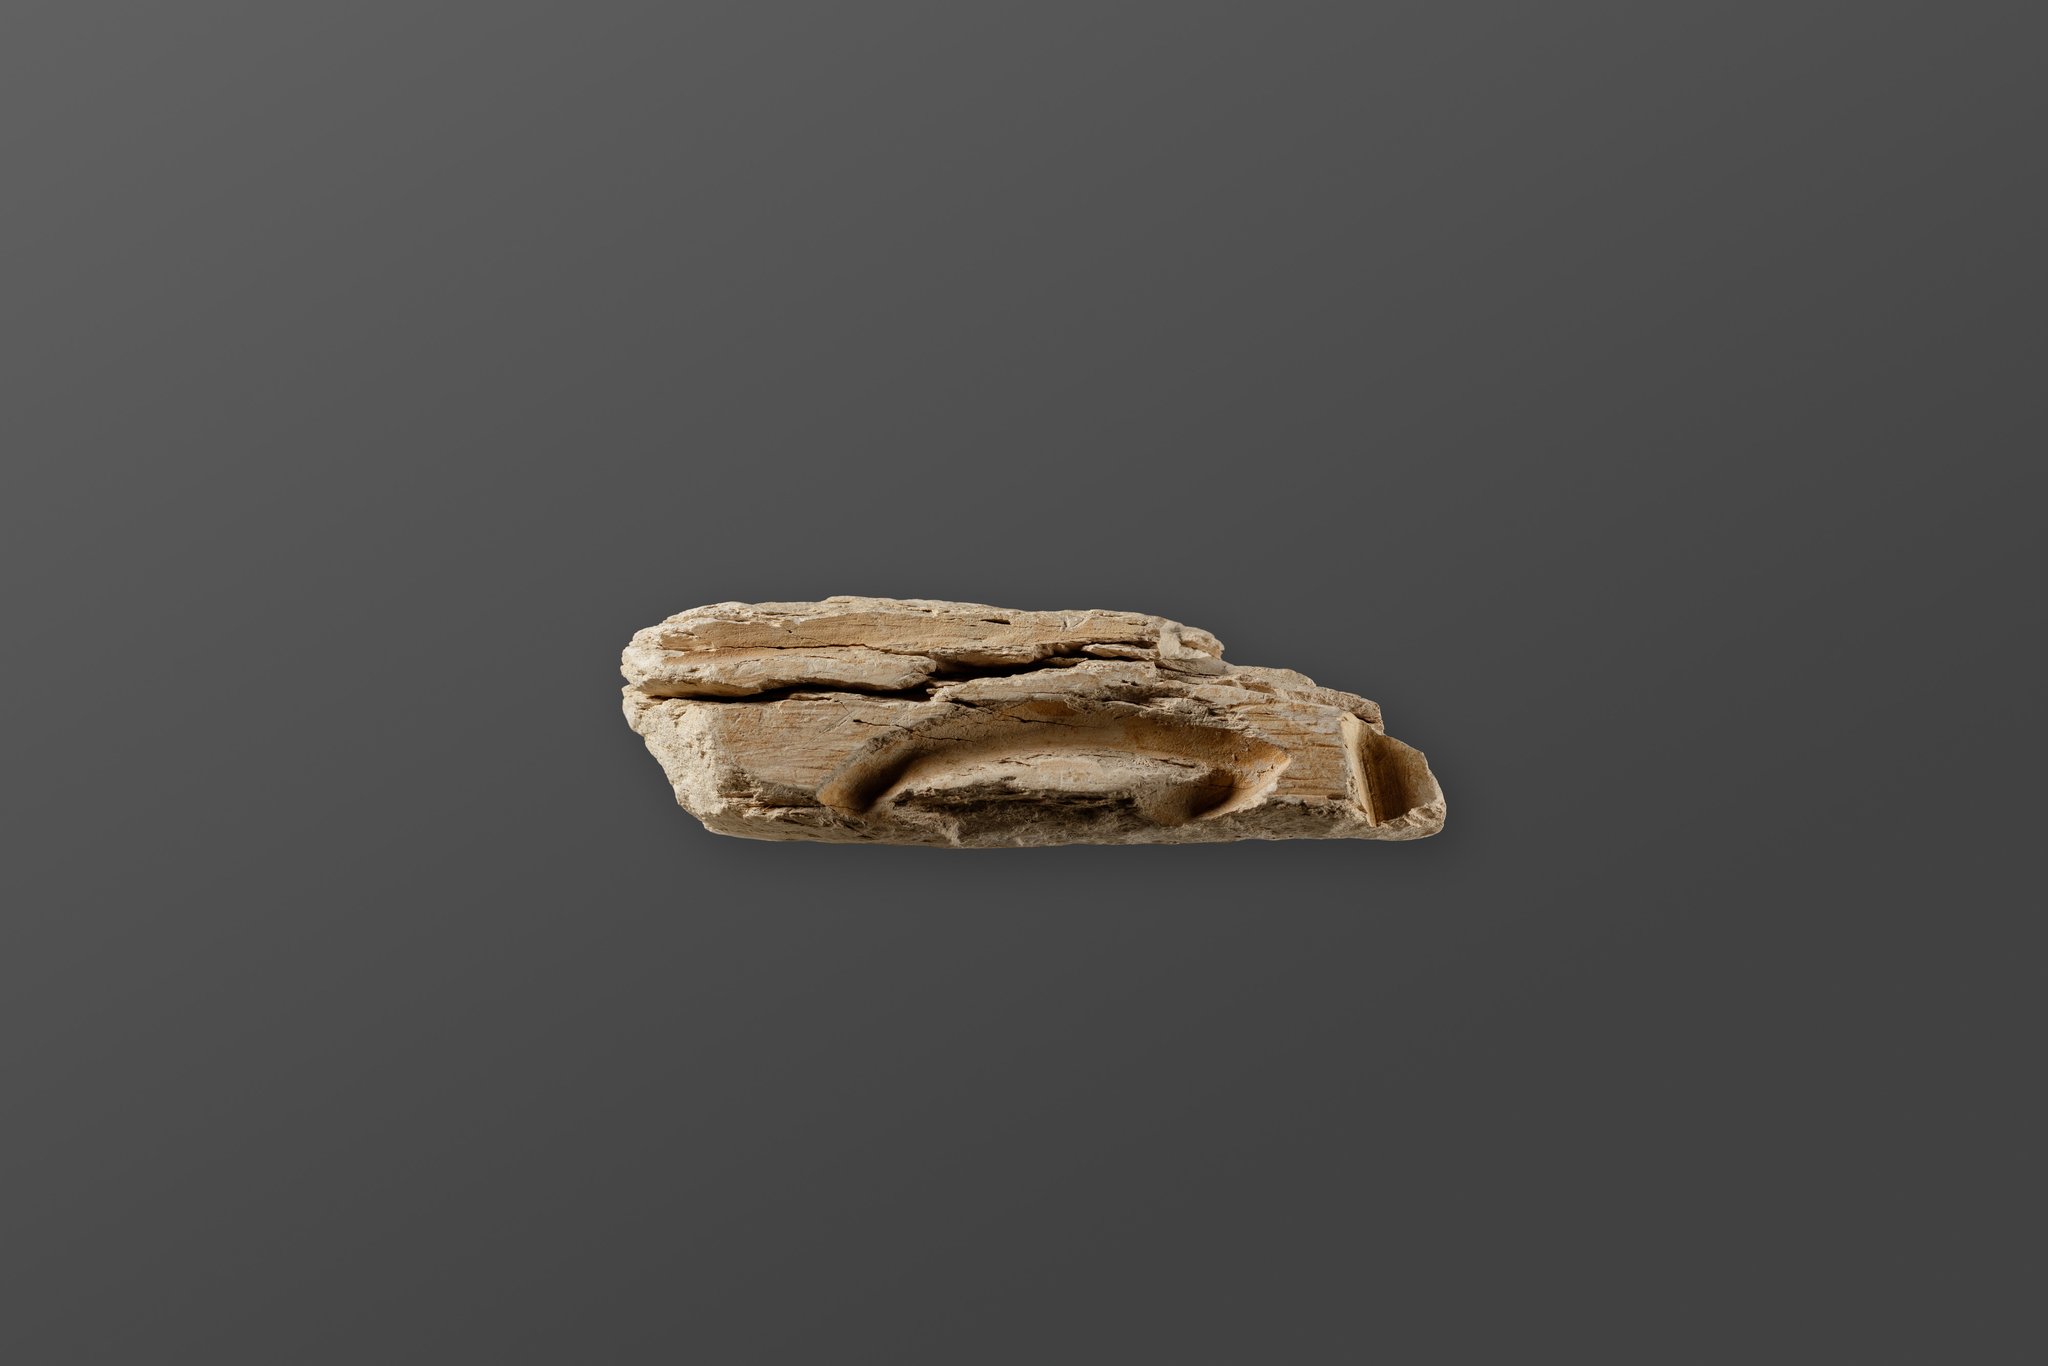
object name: relief fragment 47, tomb of mereri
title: Relief fragment possibly from the tomb of Mereri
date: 2100-2090 BCE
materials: stone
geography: egypt